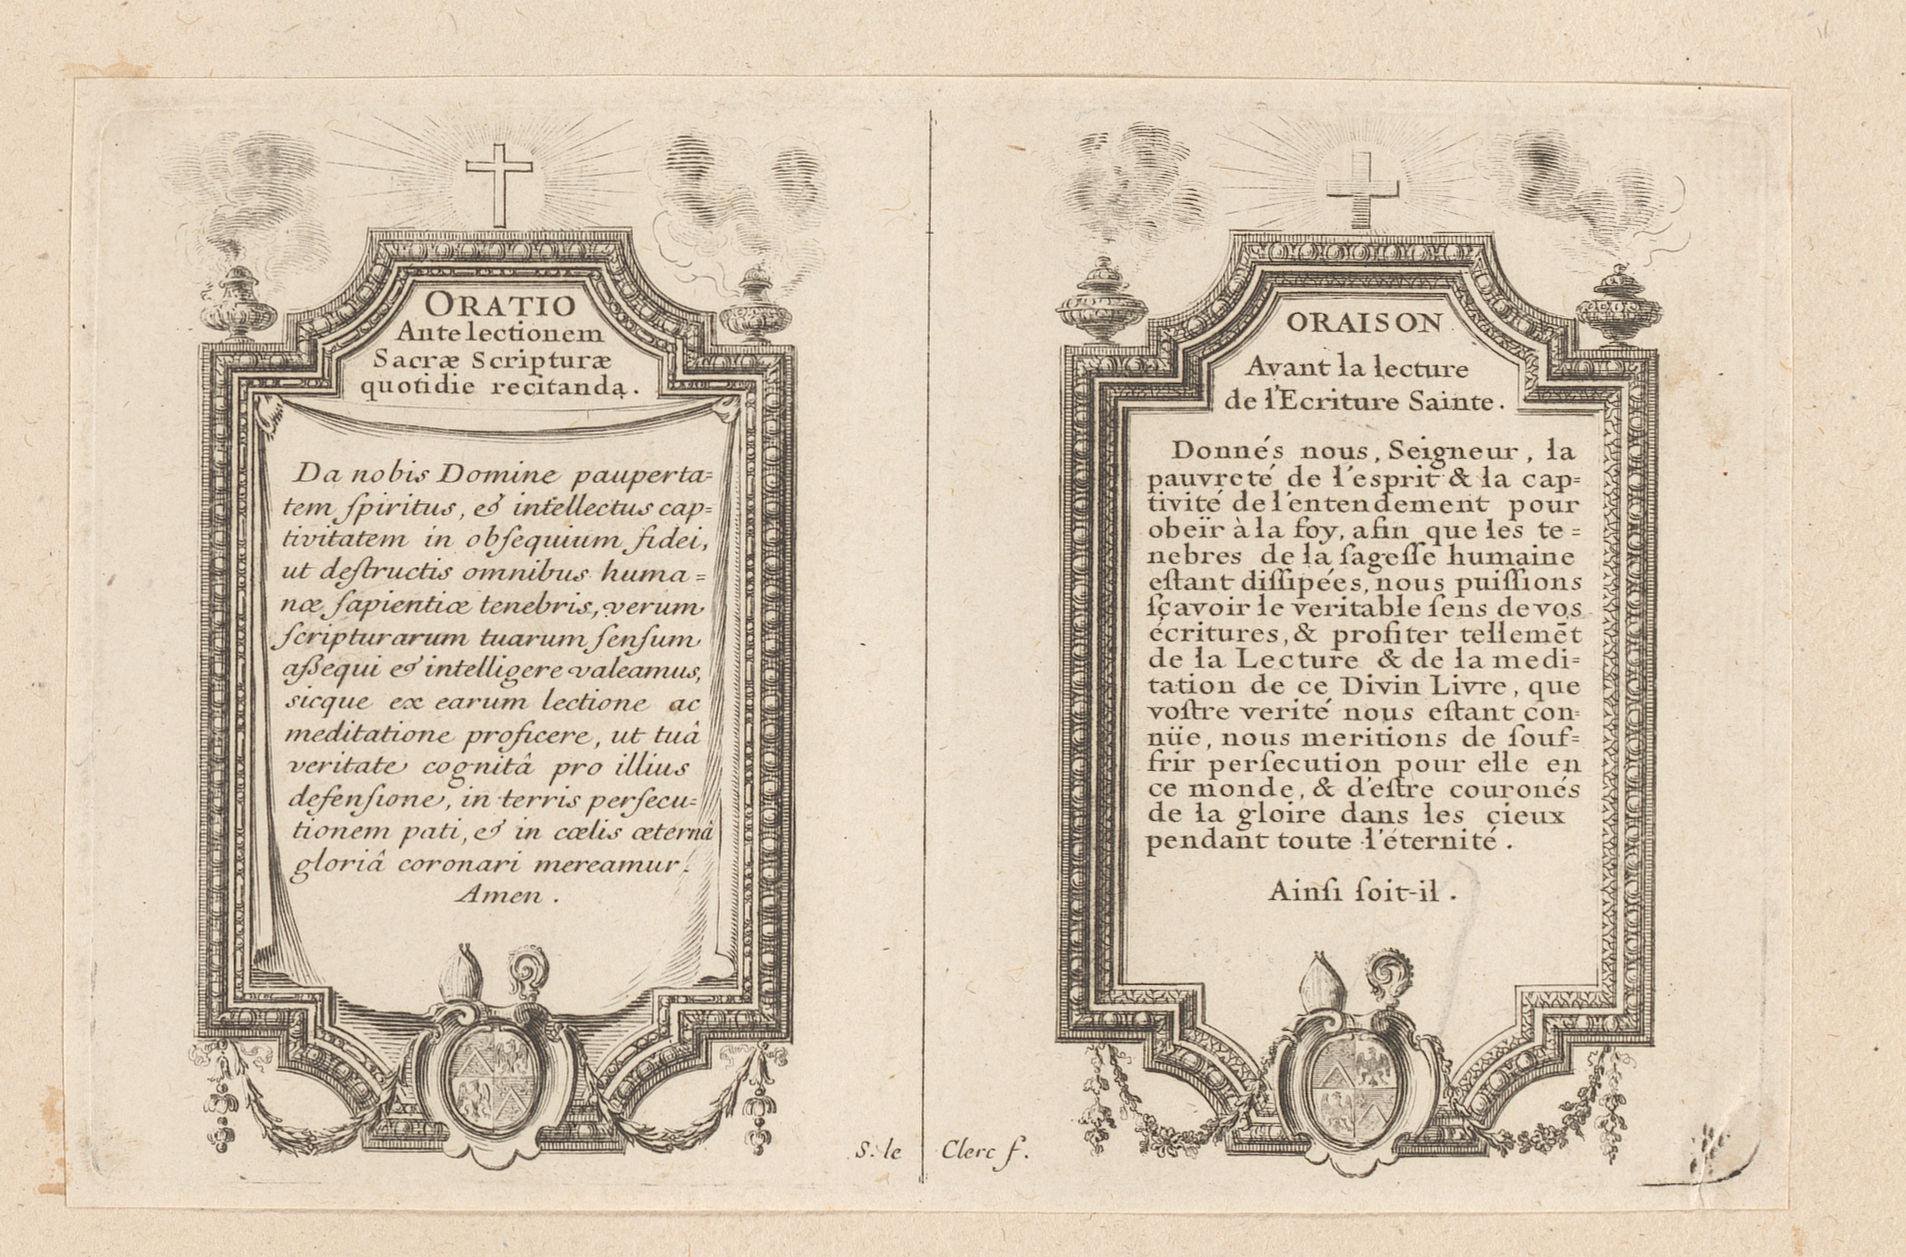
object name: album leaf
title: Twee gebeden in ornamentele lijsten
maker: sébastien leclerc (i)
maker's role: print maker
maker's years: 1637-1714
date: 1647-1714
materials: paper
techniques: etching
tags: (private) prayer; 'oratione', 'preghiere', 'preghiere a dio' (ripa)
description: Twee gebeden in ornamentele lijsten met links het gebed in het Latijn en rechts het gebed in het Frans. Met onderaan mogelijk het wapenschild van l'abbé Bouileau. Prent maakt deel uit van een album.